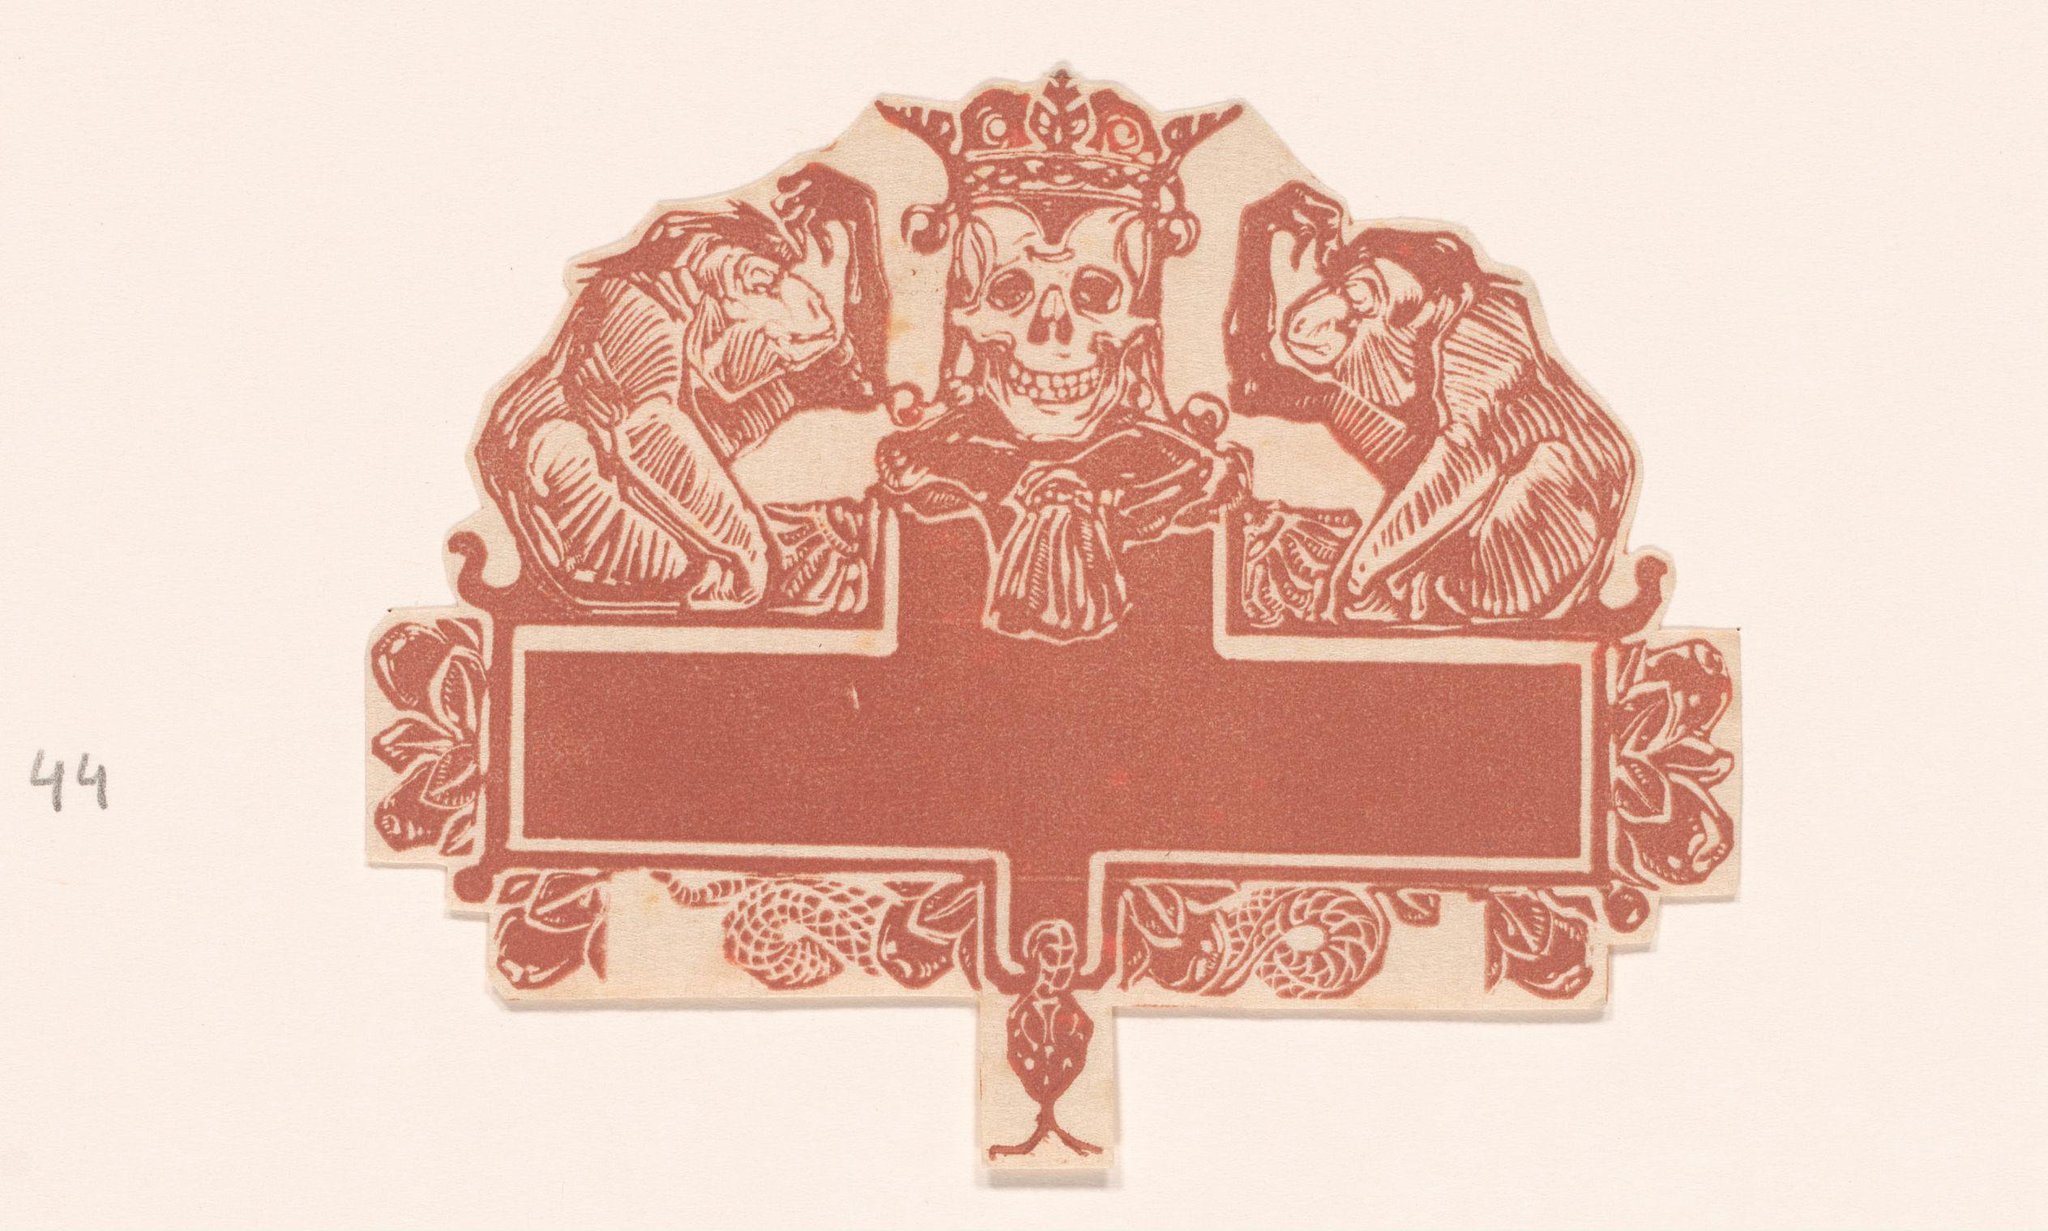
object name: boekillustratie ontwerp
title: Titelvignet met gekroond schedel en apen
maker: bernard willem wierink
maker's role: draughtsman, print maker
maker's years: 1856-1939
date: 1910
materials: paper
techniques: relief print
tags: (human) skull, monkeys, apes, fable of reynard the fox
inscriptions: collector's mark: Lugt 2228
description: Ontwerp voor: Streuvels, Stijn (Frank Lateur). Reinaert de Vos naar verschillende uitgaven van het middeleeuwsche epos. Amsterdam: L.J. Veen, 1910. Deze prent is vermoedelijk een plaatsnede, ook al wordt in de literatuur veelal gesproken over een houtsnede. Voor zover Wierink zijn prenten in hoogdruk zelf nader heeft omschreven, heeft hij altijd de term 'plaatsnede' gebruikt.